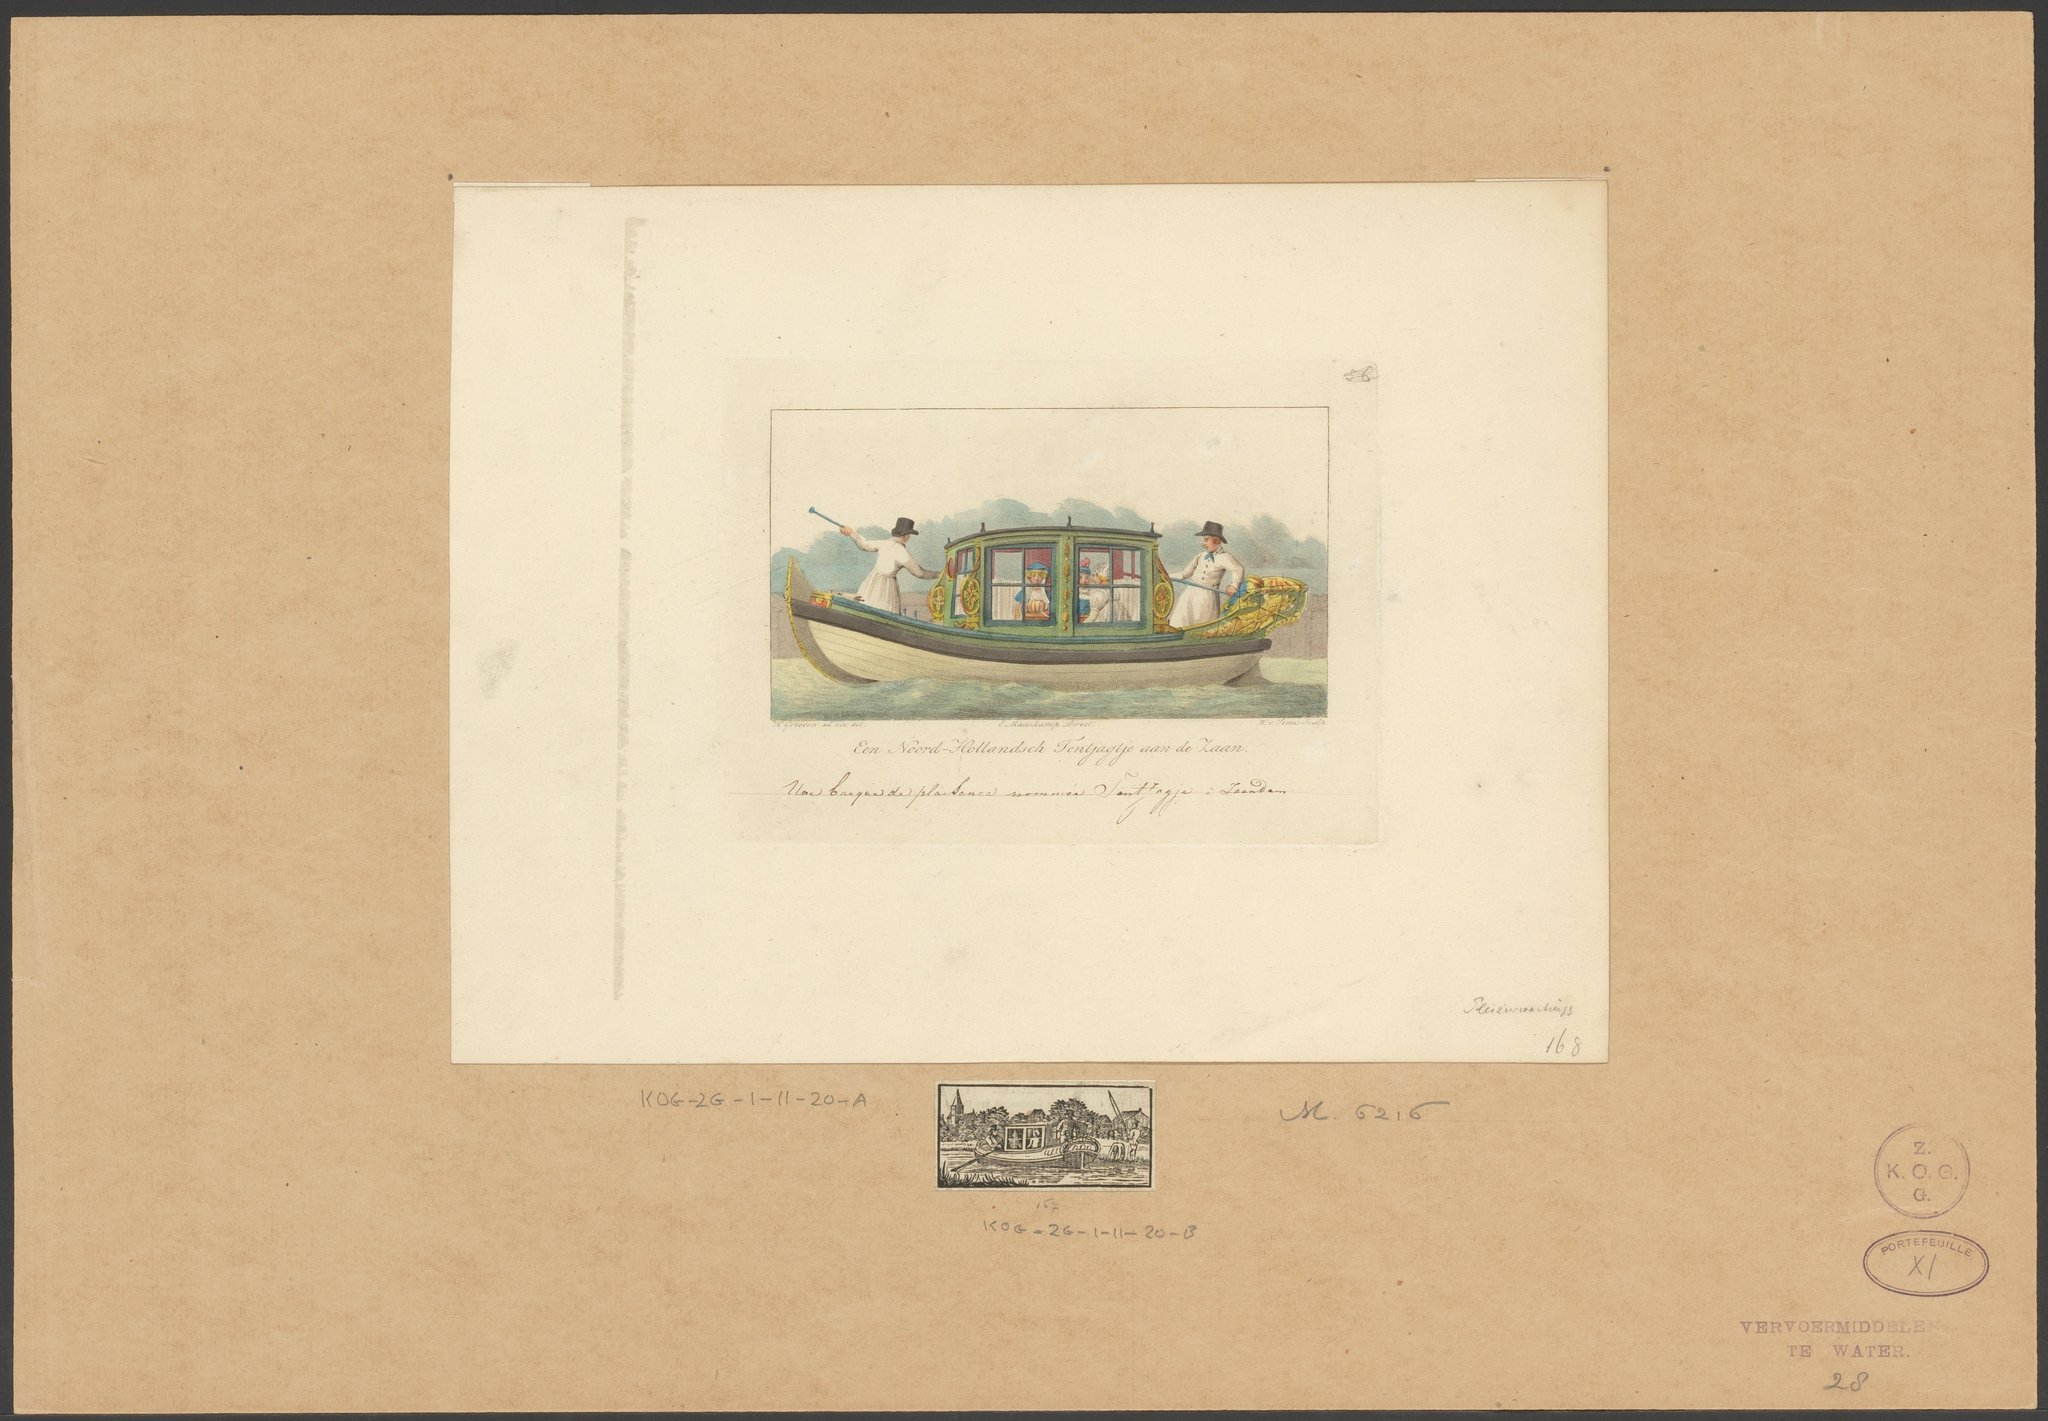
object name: print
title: Een Noord-Hollandsch Tentjagtje aan de Zaan / Une barque de plaisance nommé Tentjagje à Zaandam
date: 1787-1834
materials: paper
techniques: etching, hand coloring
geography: amsterdam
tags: ships (in general), rowing-boat, canoe, etc.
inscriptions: stamp, collector's mark: Lugt 1641, stamp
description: Onderwerpsrubrieken binnen de Atlas Zeden en Gewoonten: Handel, nijverheid en verkeer, Vervoermiddelen te land en te water, Vervoermiddelen te water.